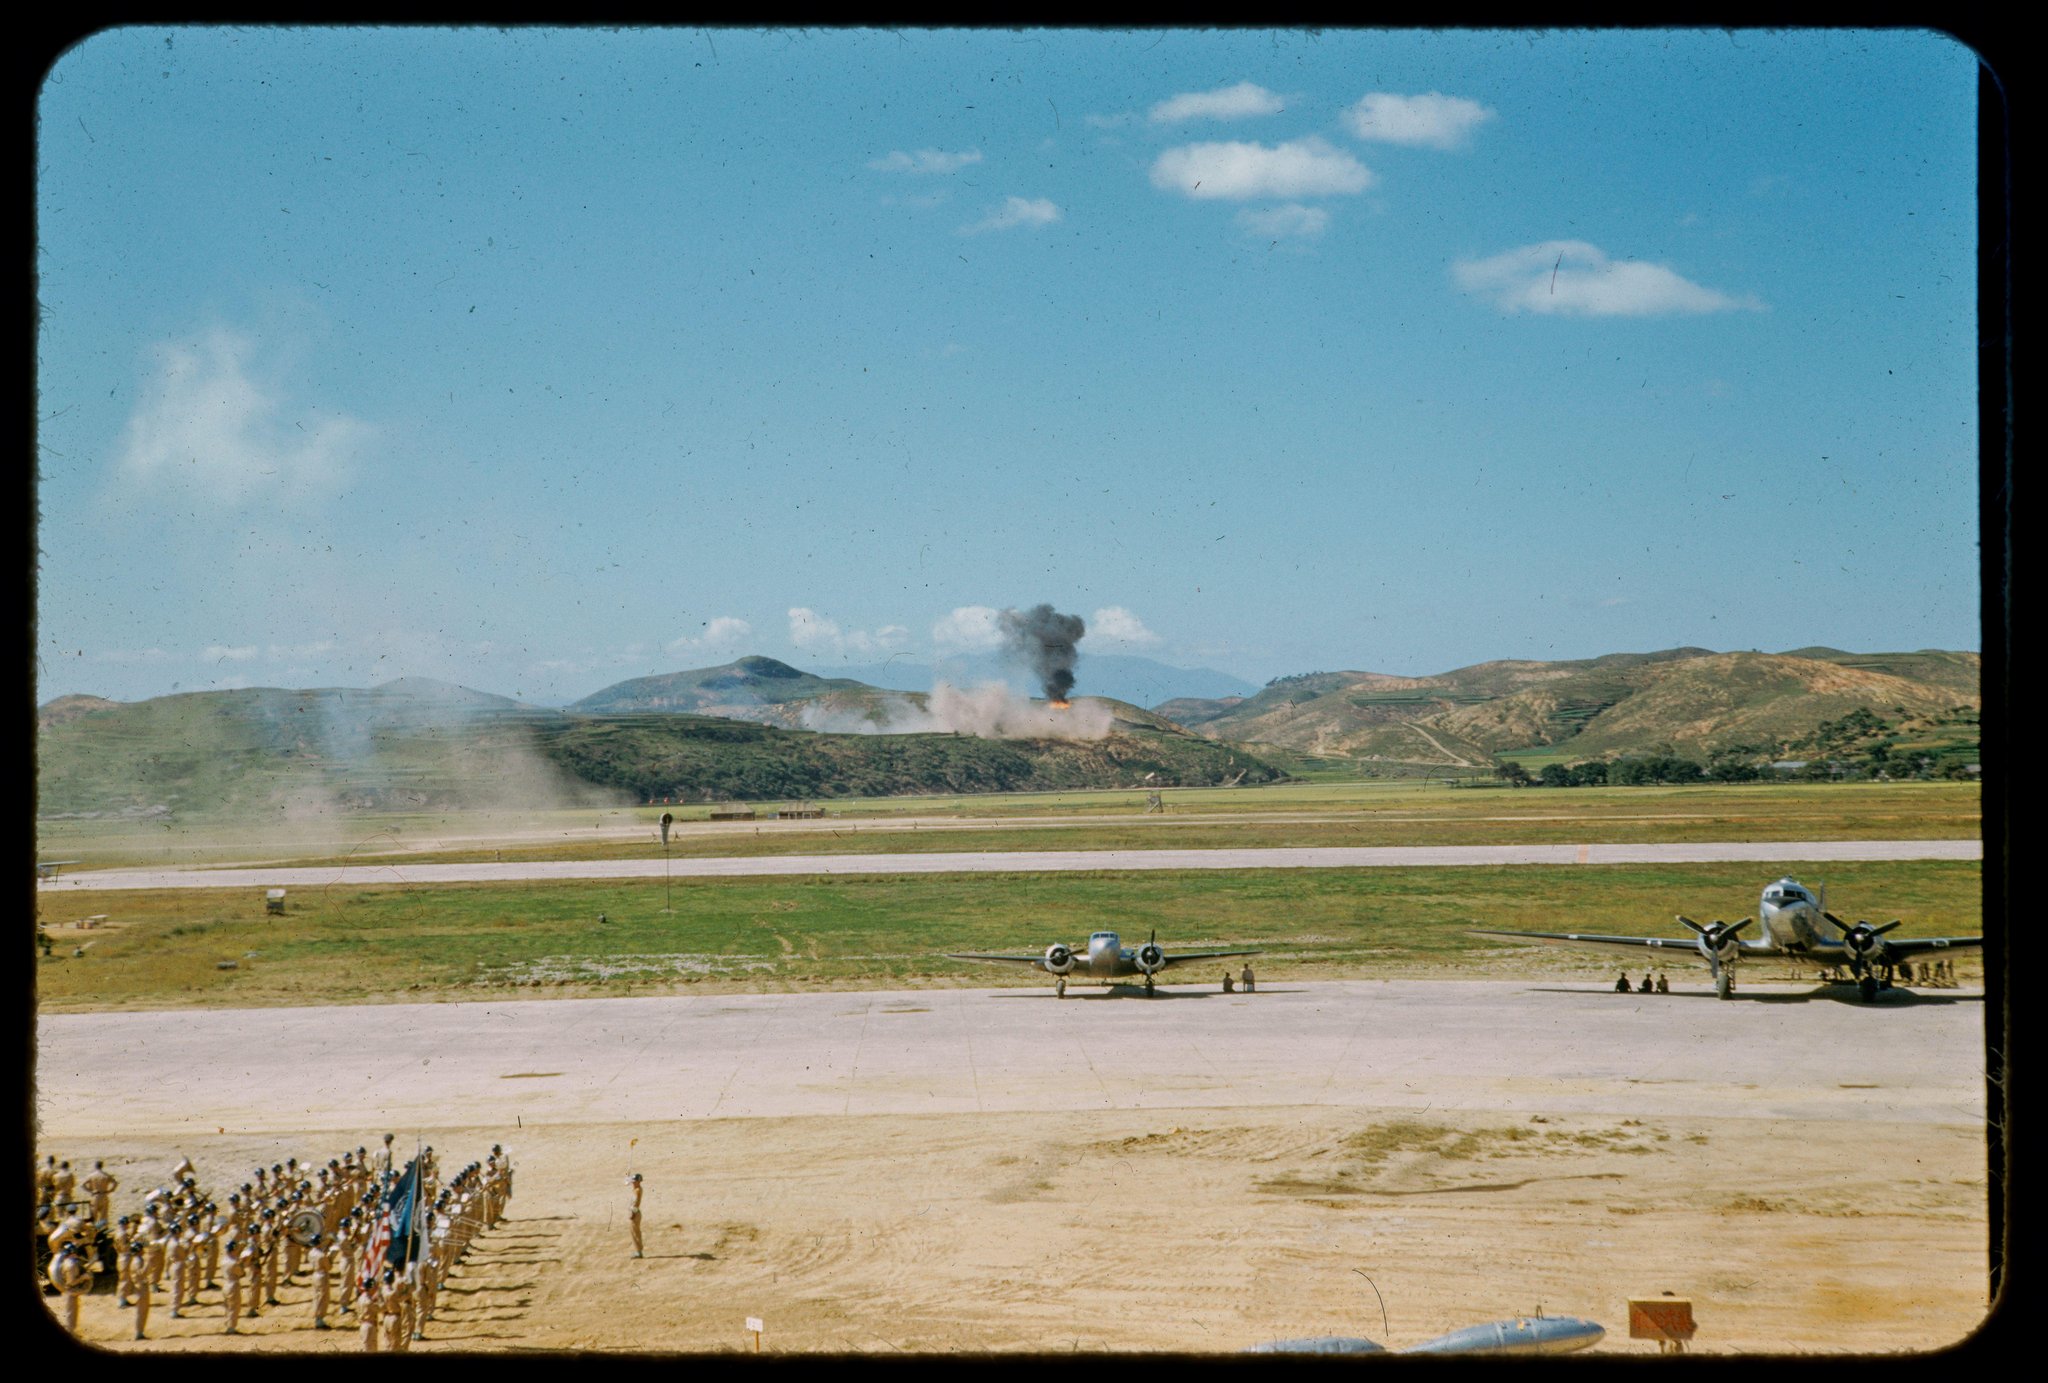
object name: color slide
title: Oorlog in Korea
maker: david ketel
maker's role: diplomaat, sinoloog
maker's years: 1913-2008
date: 1909-1952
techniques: slide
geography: korea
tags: united nations